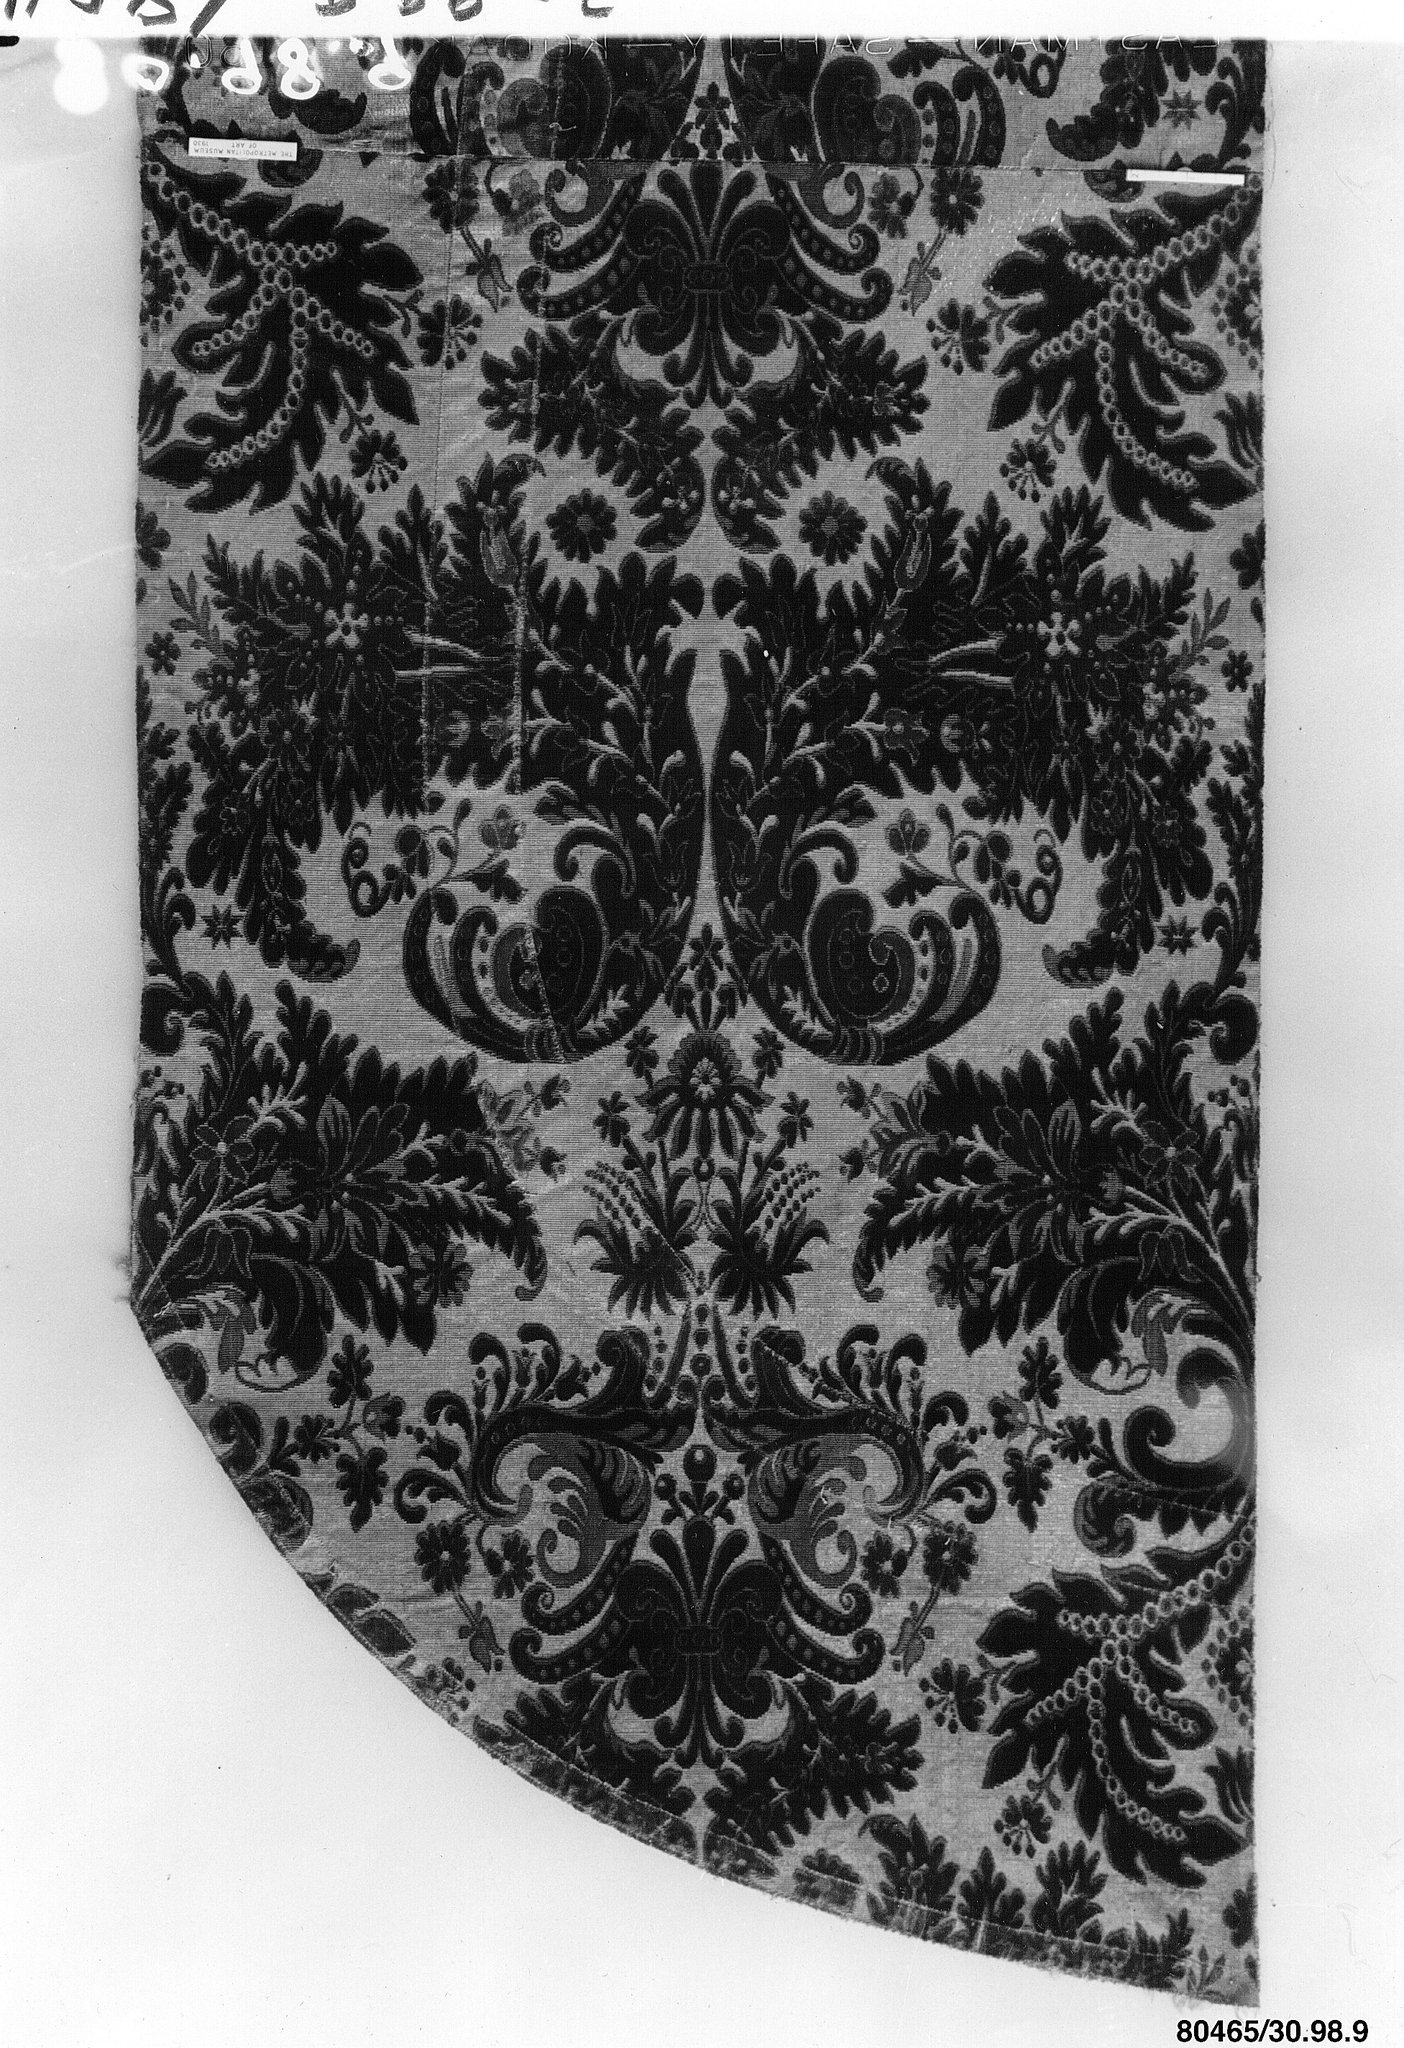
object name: piece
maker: poliakoff, moscow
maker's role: manufacturer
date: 1701-1800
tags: flowers,leaves